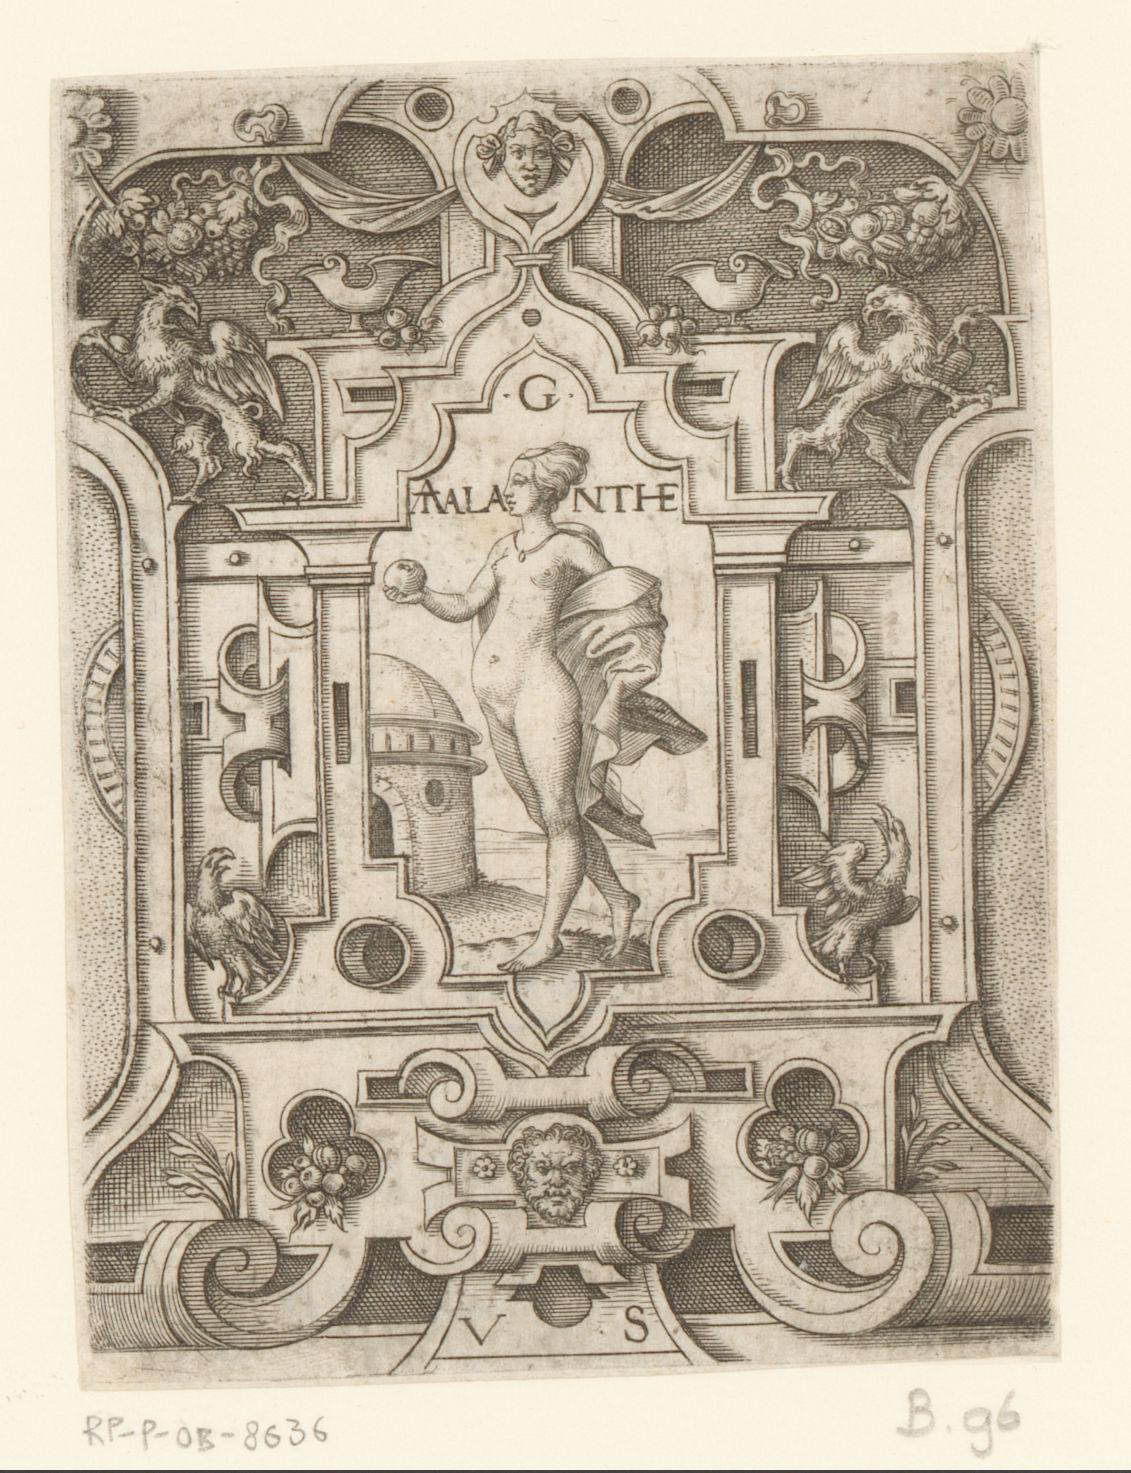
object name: print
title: Atalanta in een rolwerk omlijsting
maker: virgilius solis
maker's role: draughtsman, print maker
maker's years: 1514-1562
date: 1524-1562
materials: paper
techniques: engraving, etching, intaglio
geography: nuremberg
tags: scrollwork, strapwork ~ ornament, atalanta and meleager as lovers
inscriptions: collector's mark: Lugt 2228, number: ‘123’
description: Maakt deel uit van een serie van twaalf prenten met vrouwelijke mythologische figuren staand in rolwerk omlijstingen.